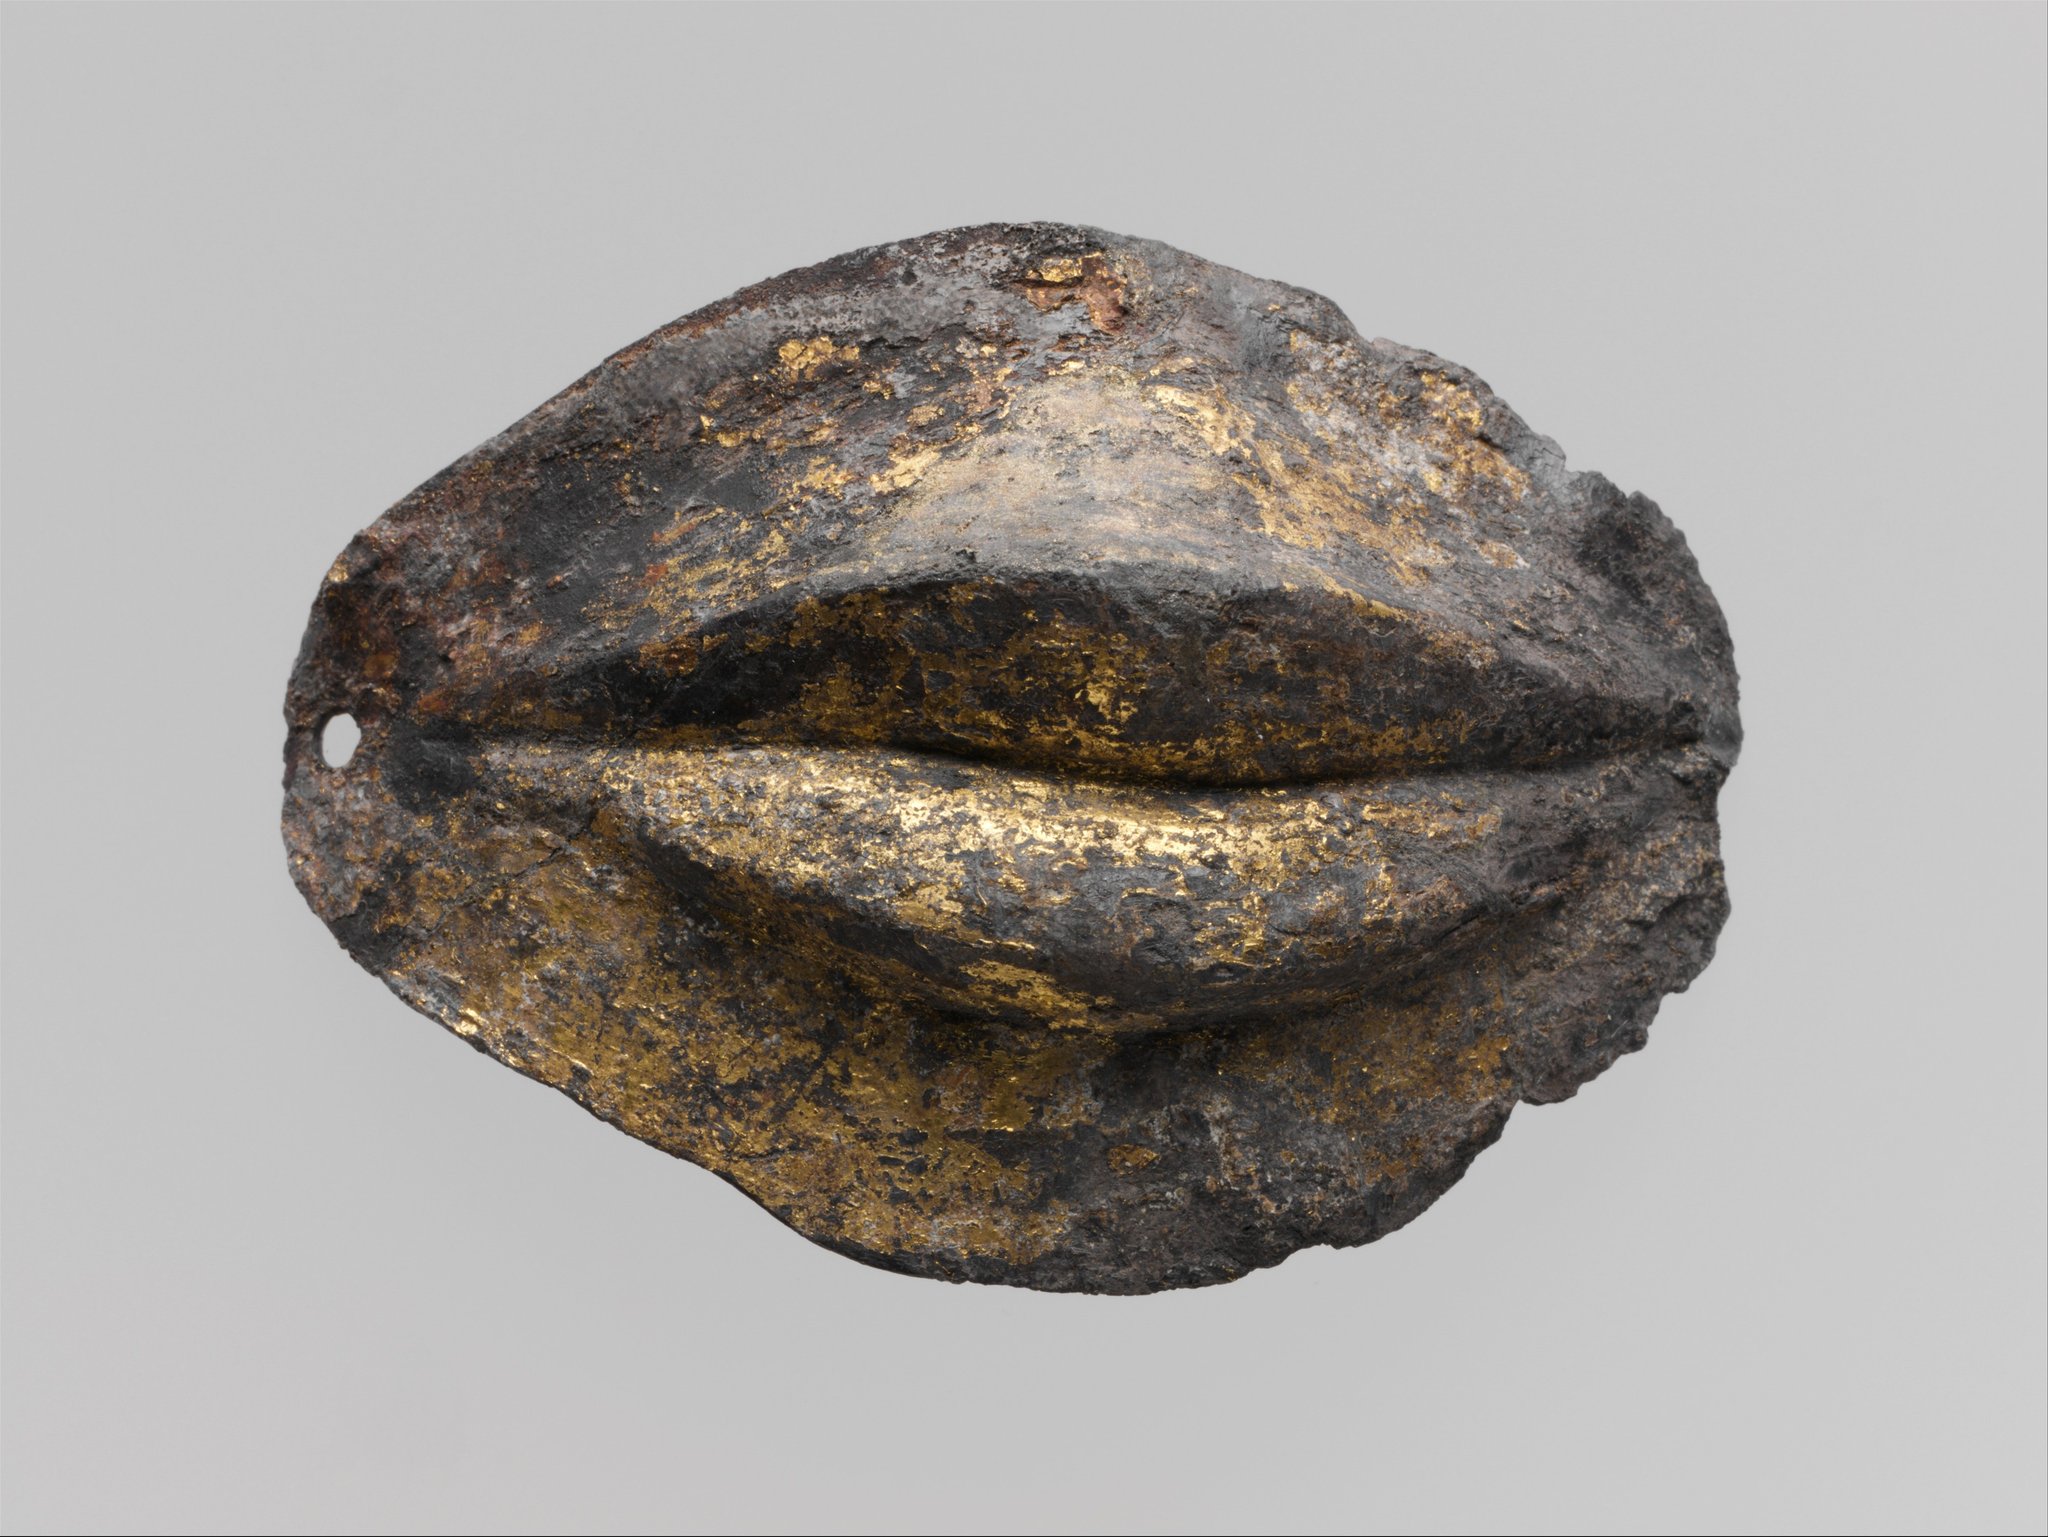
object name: mouth plate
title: Silver-gilt mouthpiece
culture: cypriot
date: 534-401 BCE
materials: gilt silver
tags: mouths